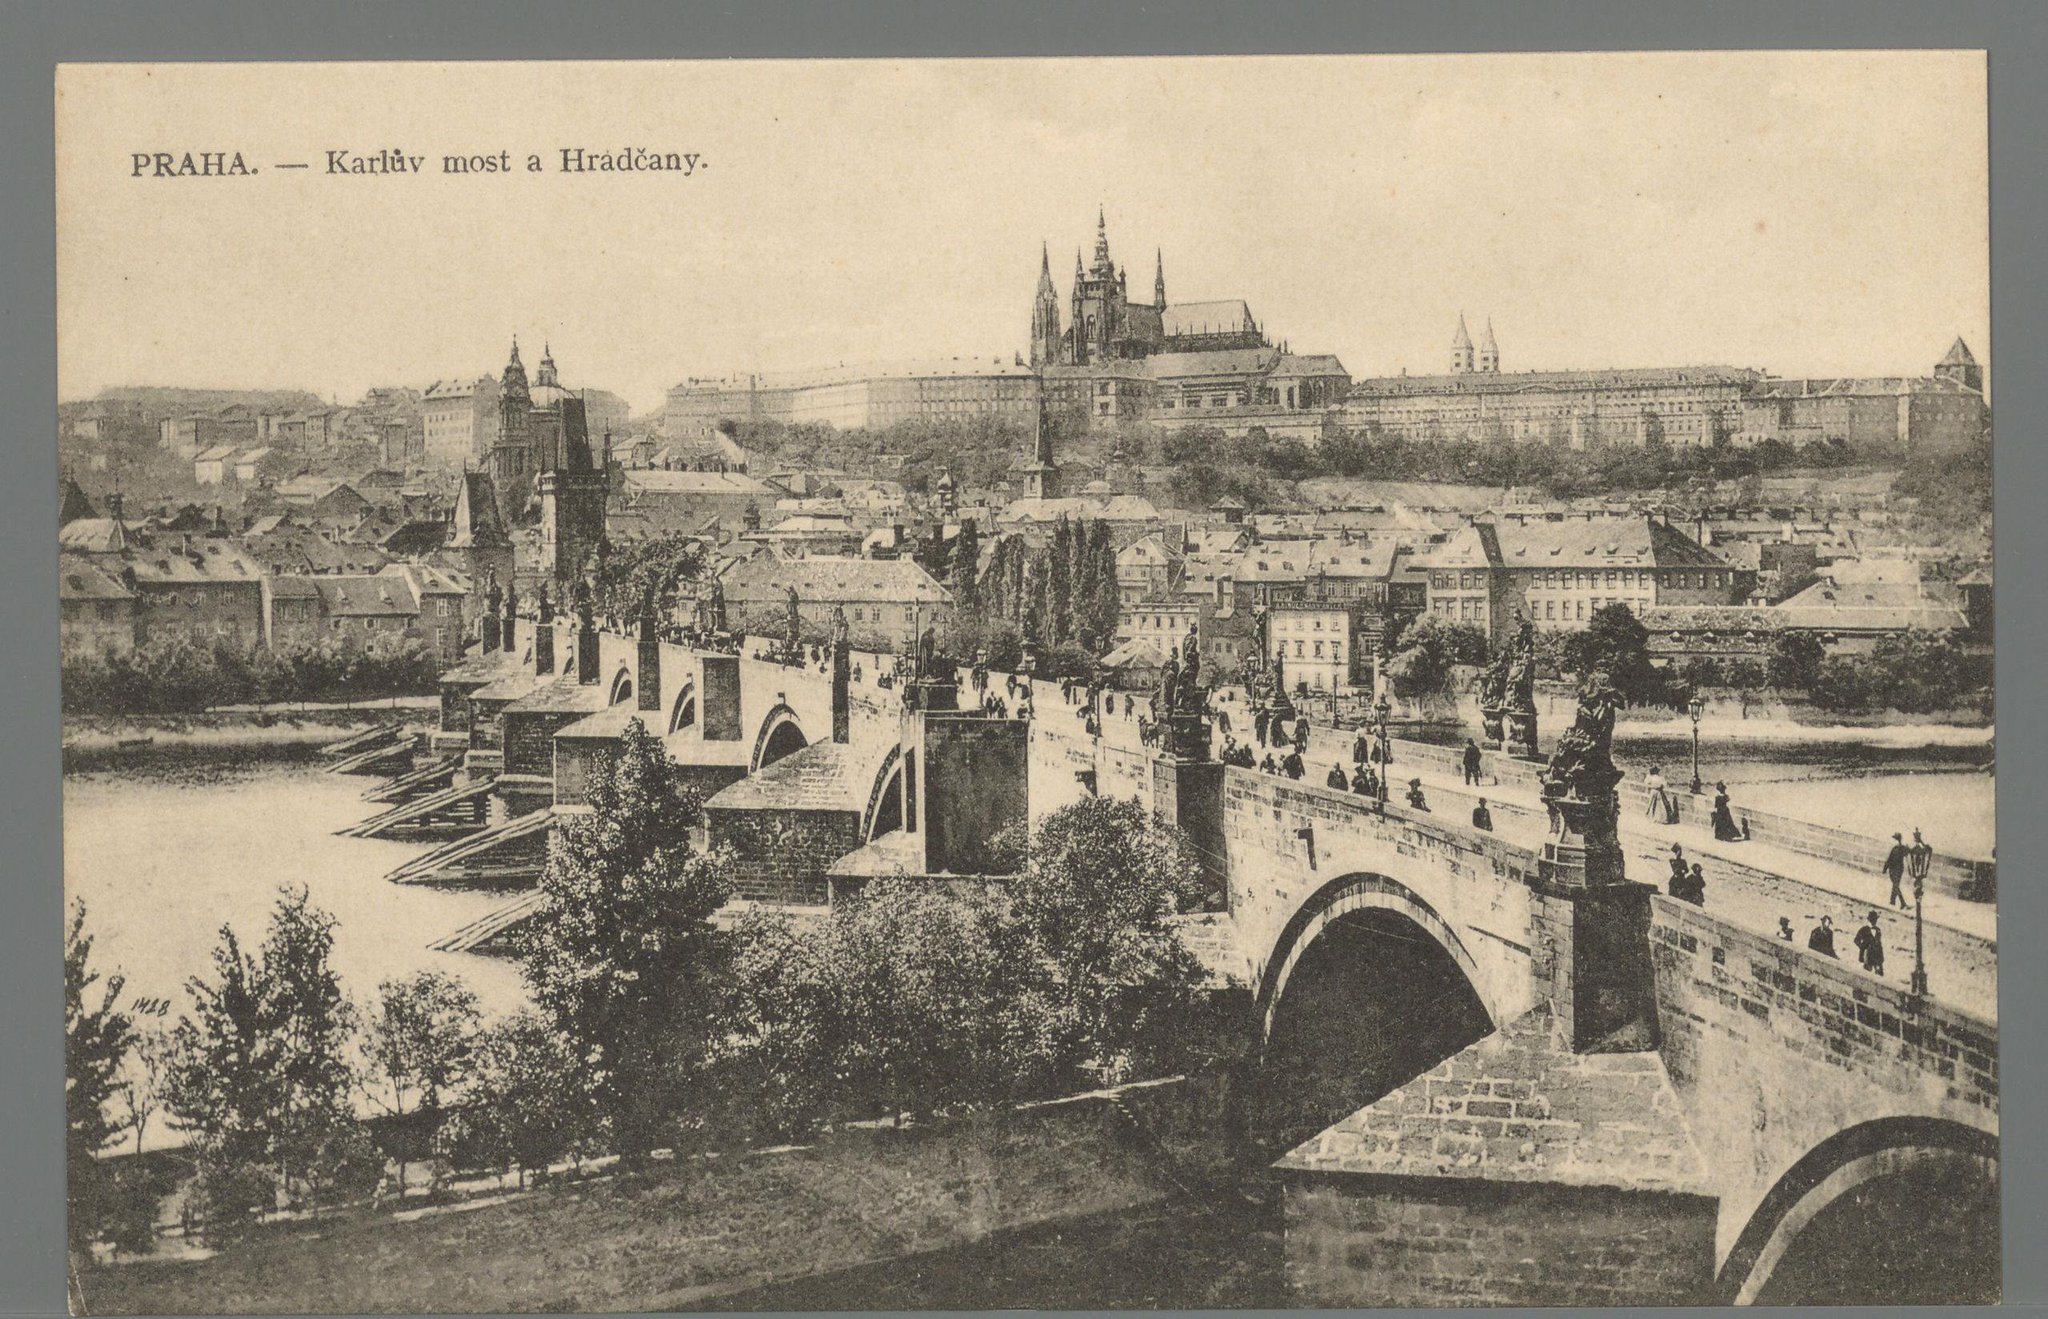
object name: ansichtkaart, prentbriefkaart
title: Praha - Karluv most a Hradčany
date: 1910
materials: cardboard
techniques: photograph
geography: prague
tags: castle, church (exterior), canals, waters (in city), bridge in city across river, canal, etc.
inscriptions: date